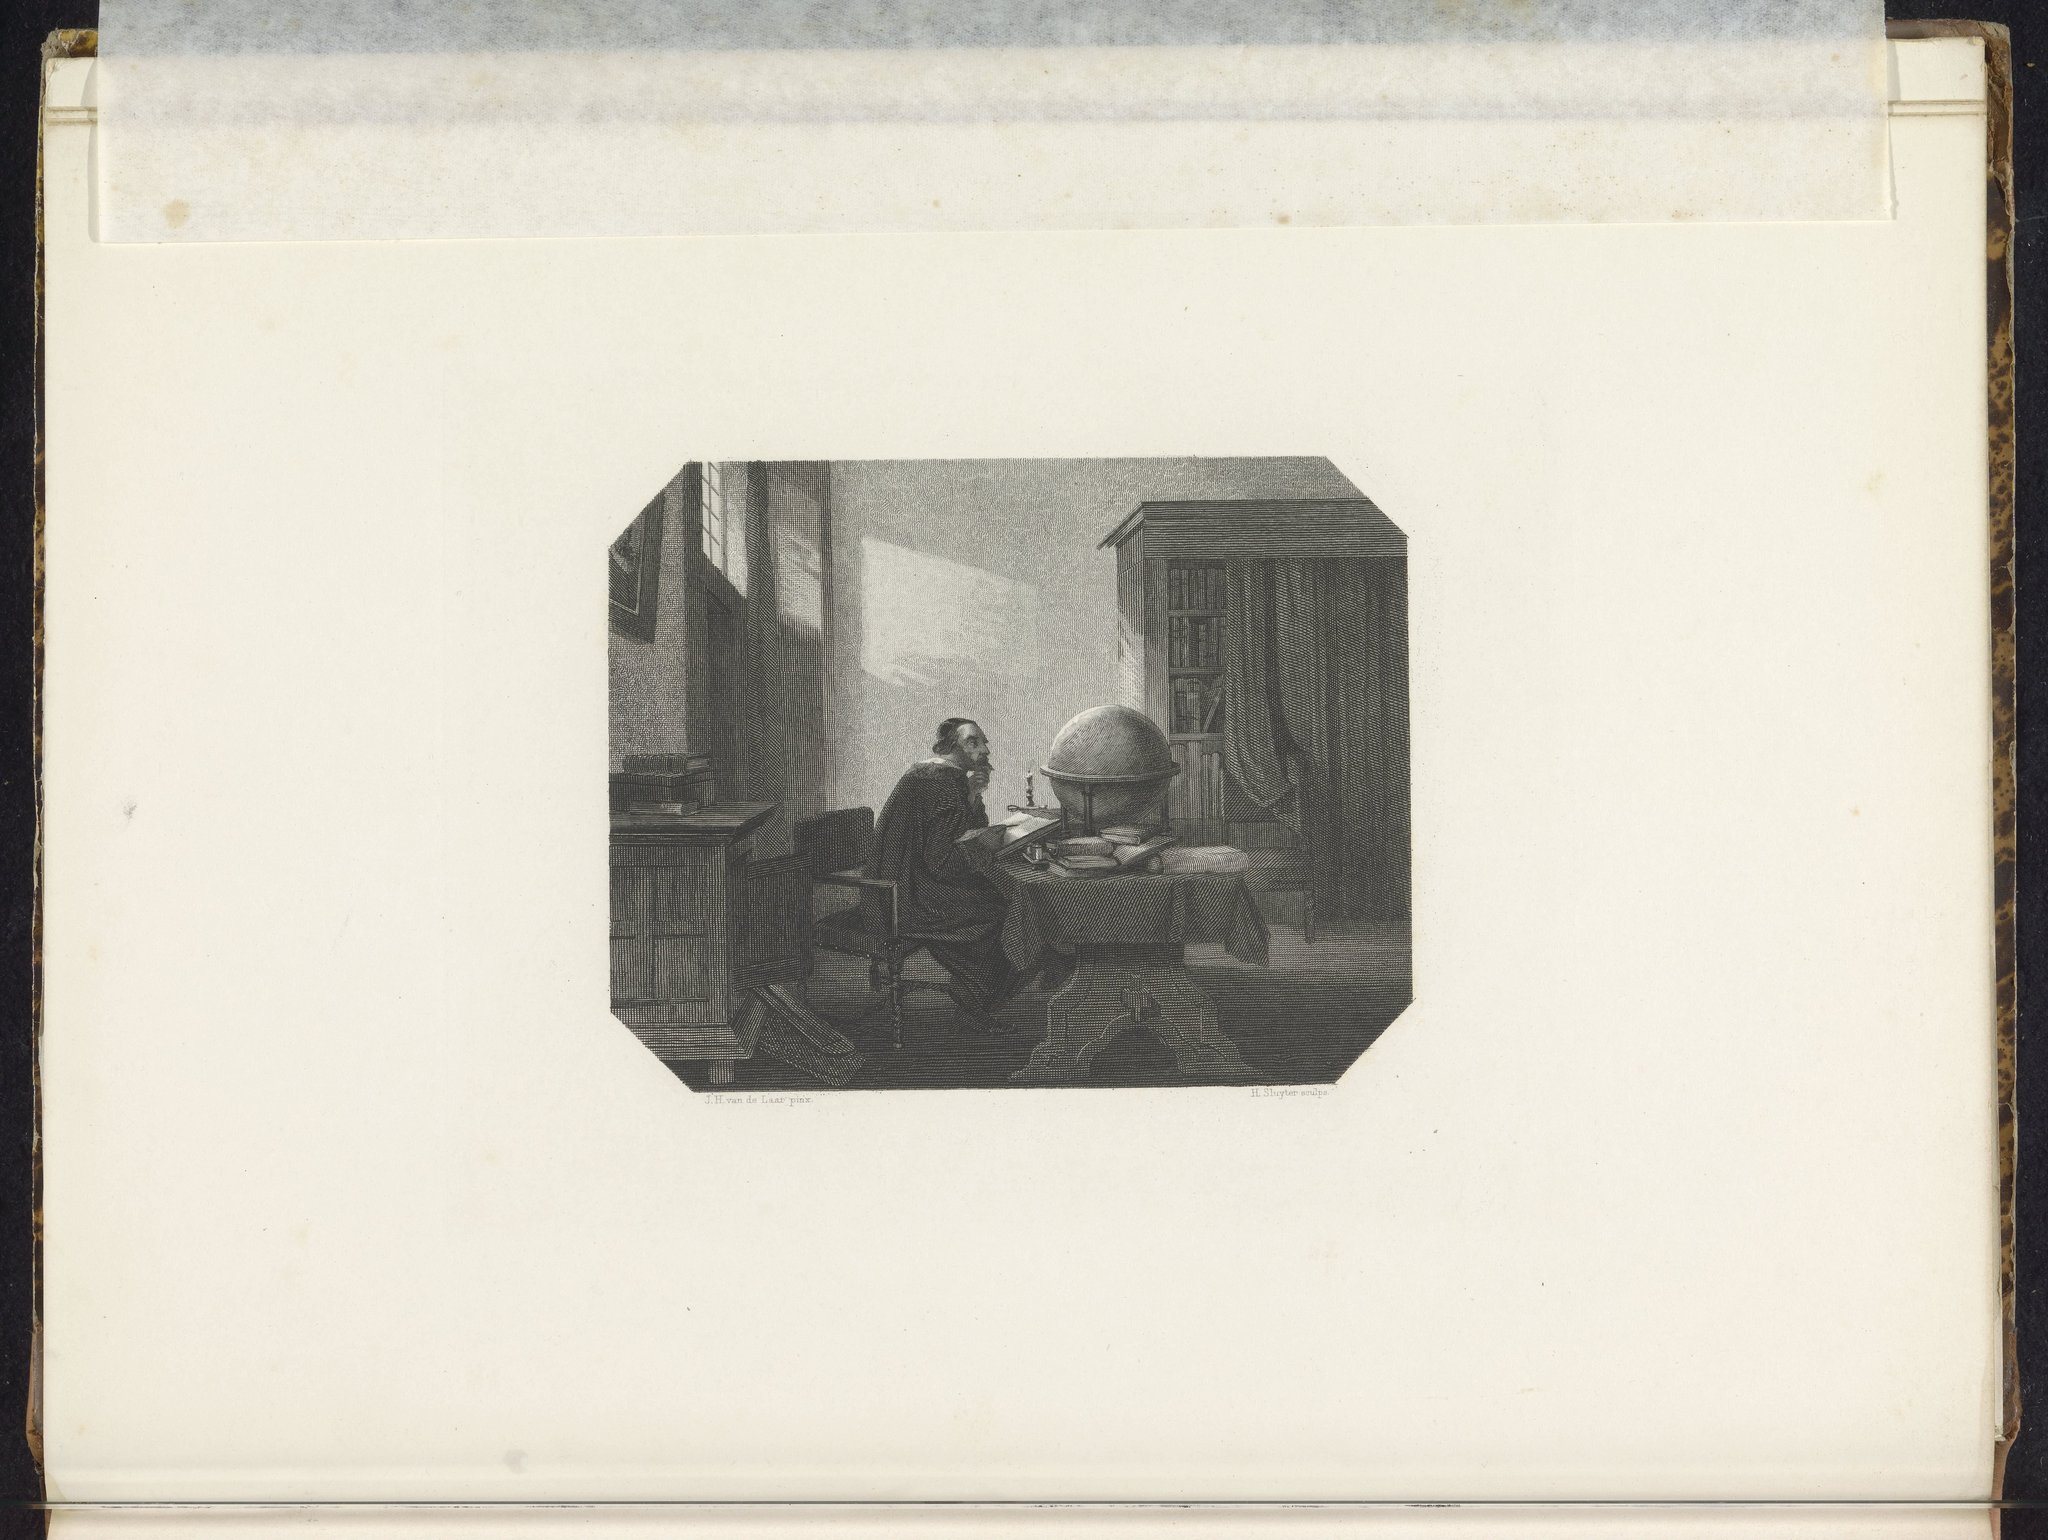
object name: history print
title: Metius, ca. 1600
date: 1865-1870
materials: paper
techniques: engraving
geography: netherlands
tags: adriaan adriaansz. metius, mathematics (+ scholar, scientist (at work))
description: Portret van de wiskundige Adriaan Adriaansz., bijgenaamd Metius, in zijn studeerkamer, ca. 1600. Onderdeel van de groep staalgravures naar de schilderijen van de Historische Galerij der Maatschappij Arti et Amicitiae.